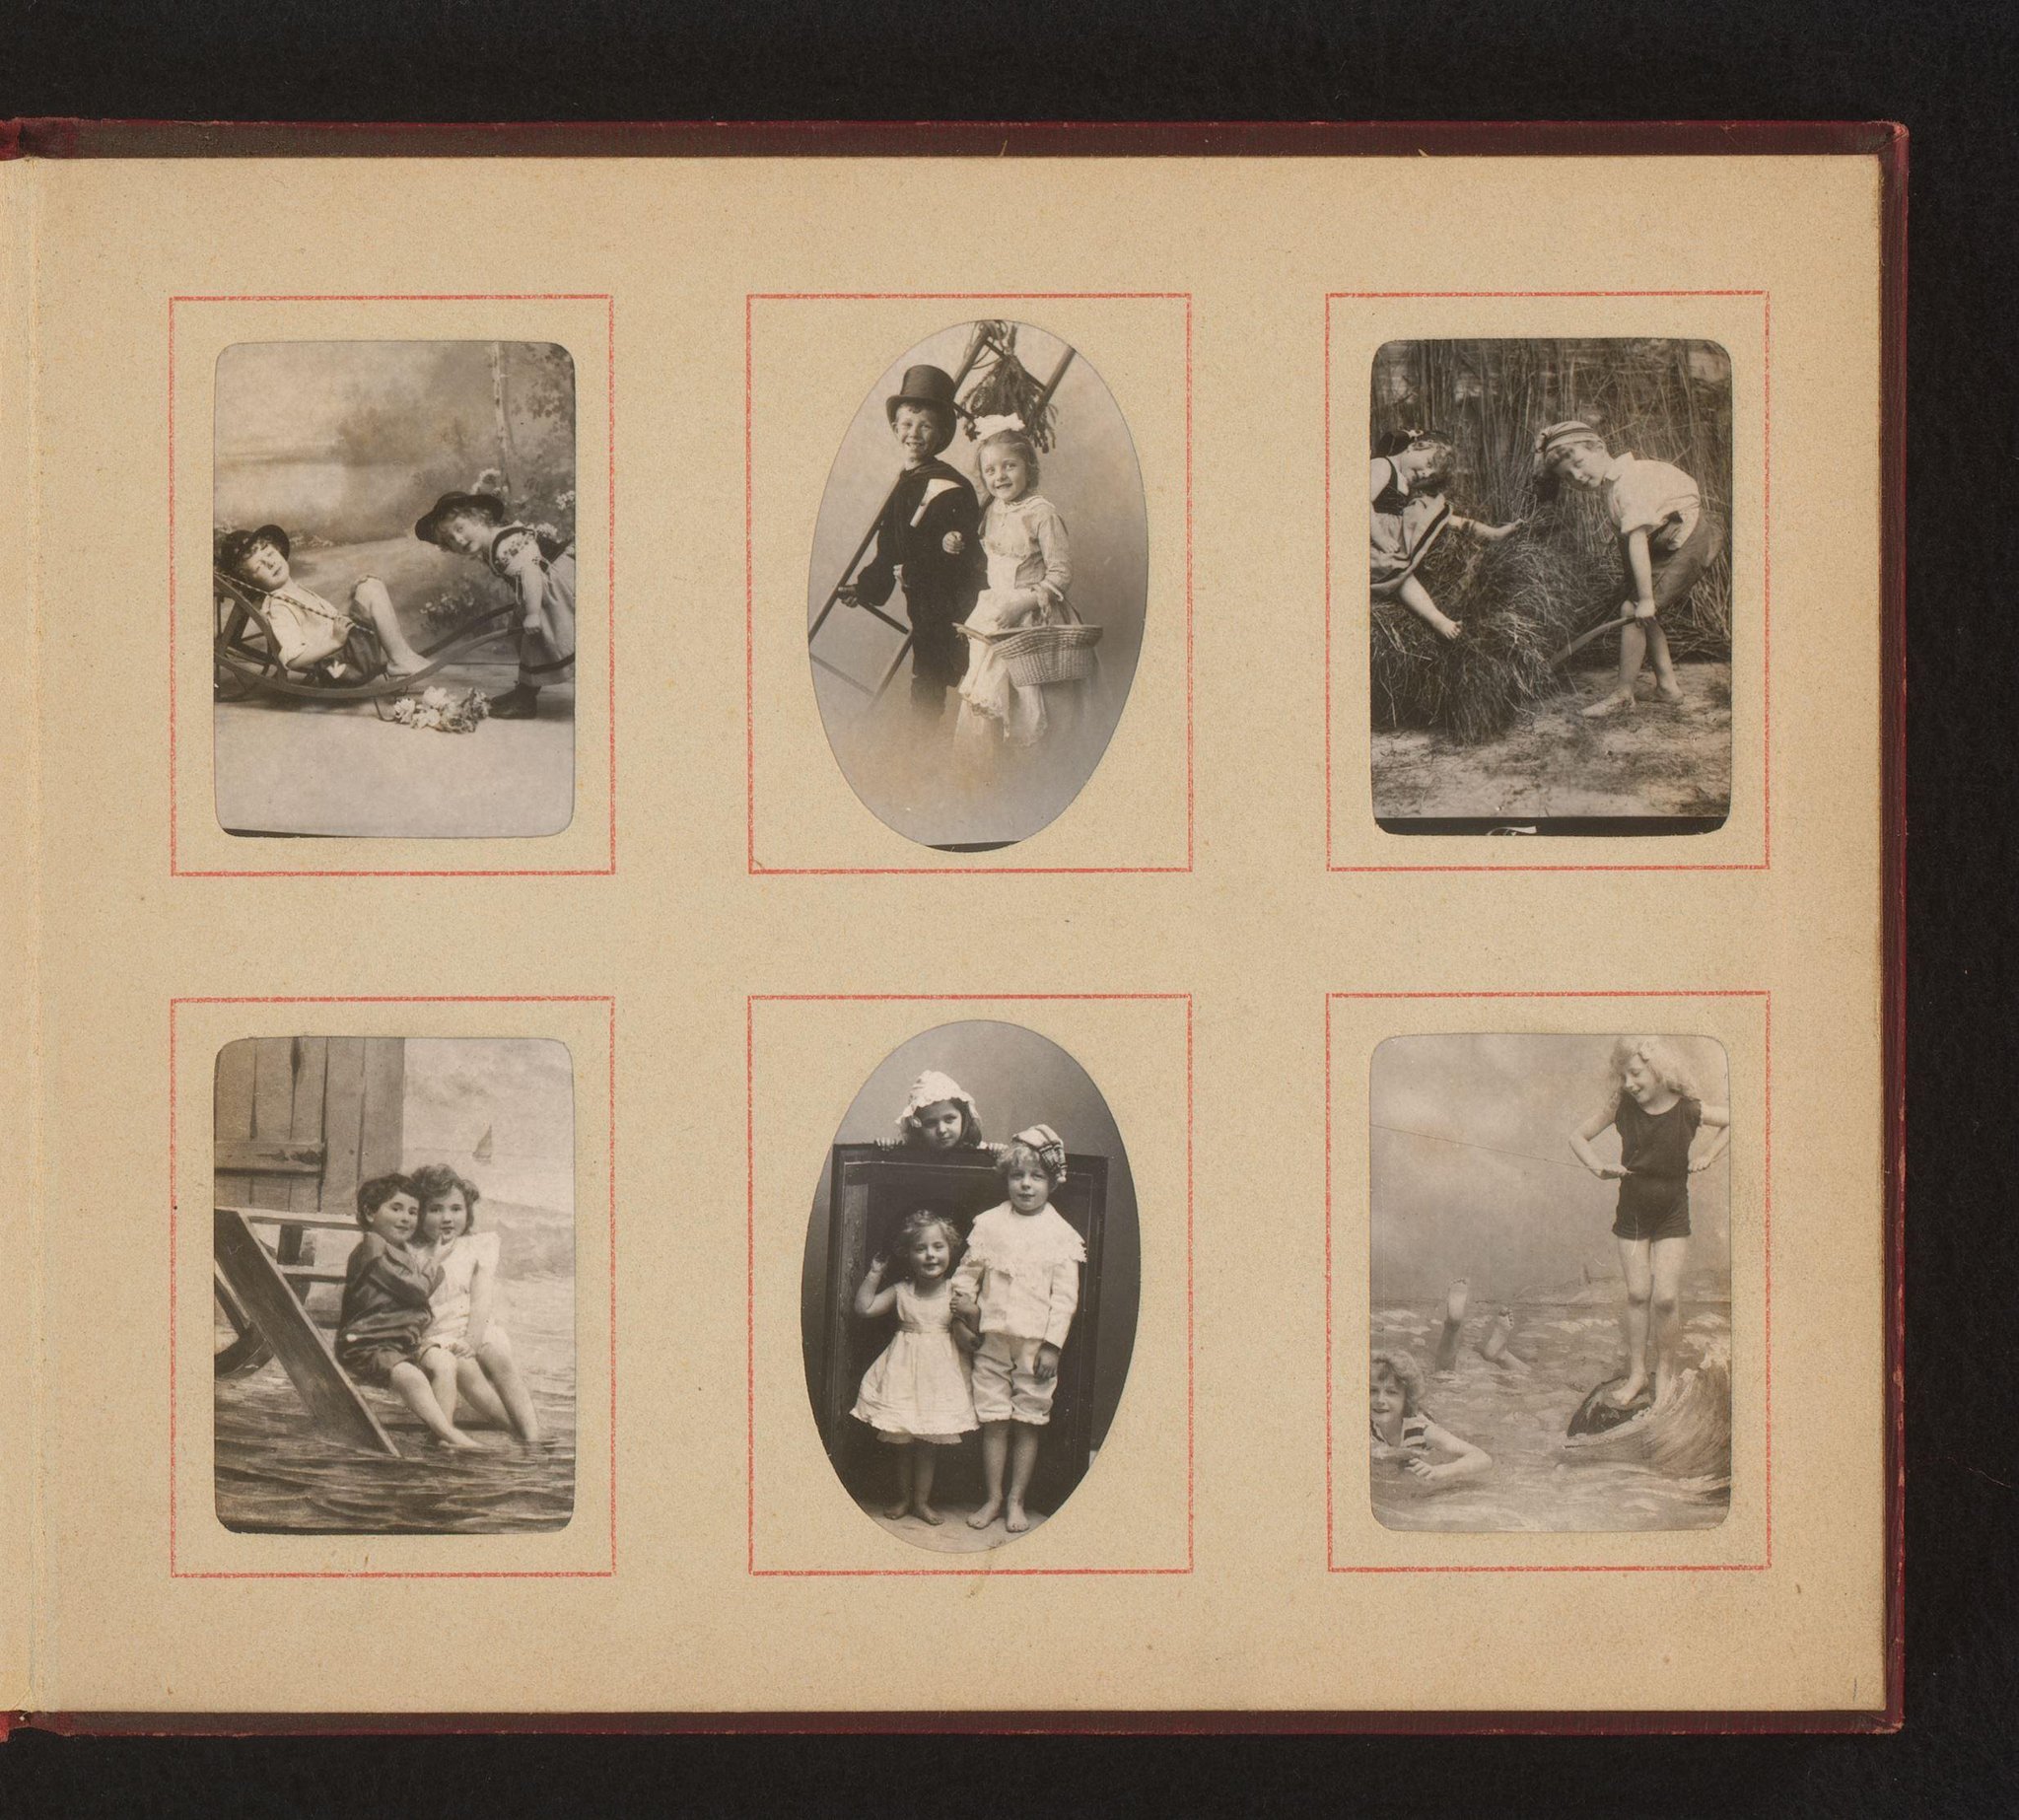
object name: reproduction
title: Kinderportretten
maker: Anonymous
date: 1880-1920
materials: photographic support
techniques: gelatin silver print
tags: child, historical persons, painting, drawing and the graphic arts, trade games, imitative games, imitating adults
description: Zes portretten van kinderen, waaronder een fotoreproductie van een schilderij van twee kinderen met de voeten in het water. Deze pagina maakt deel uit van een album.